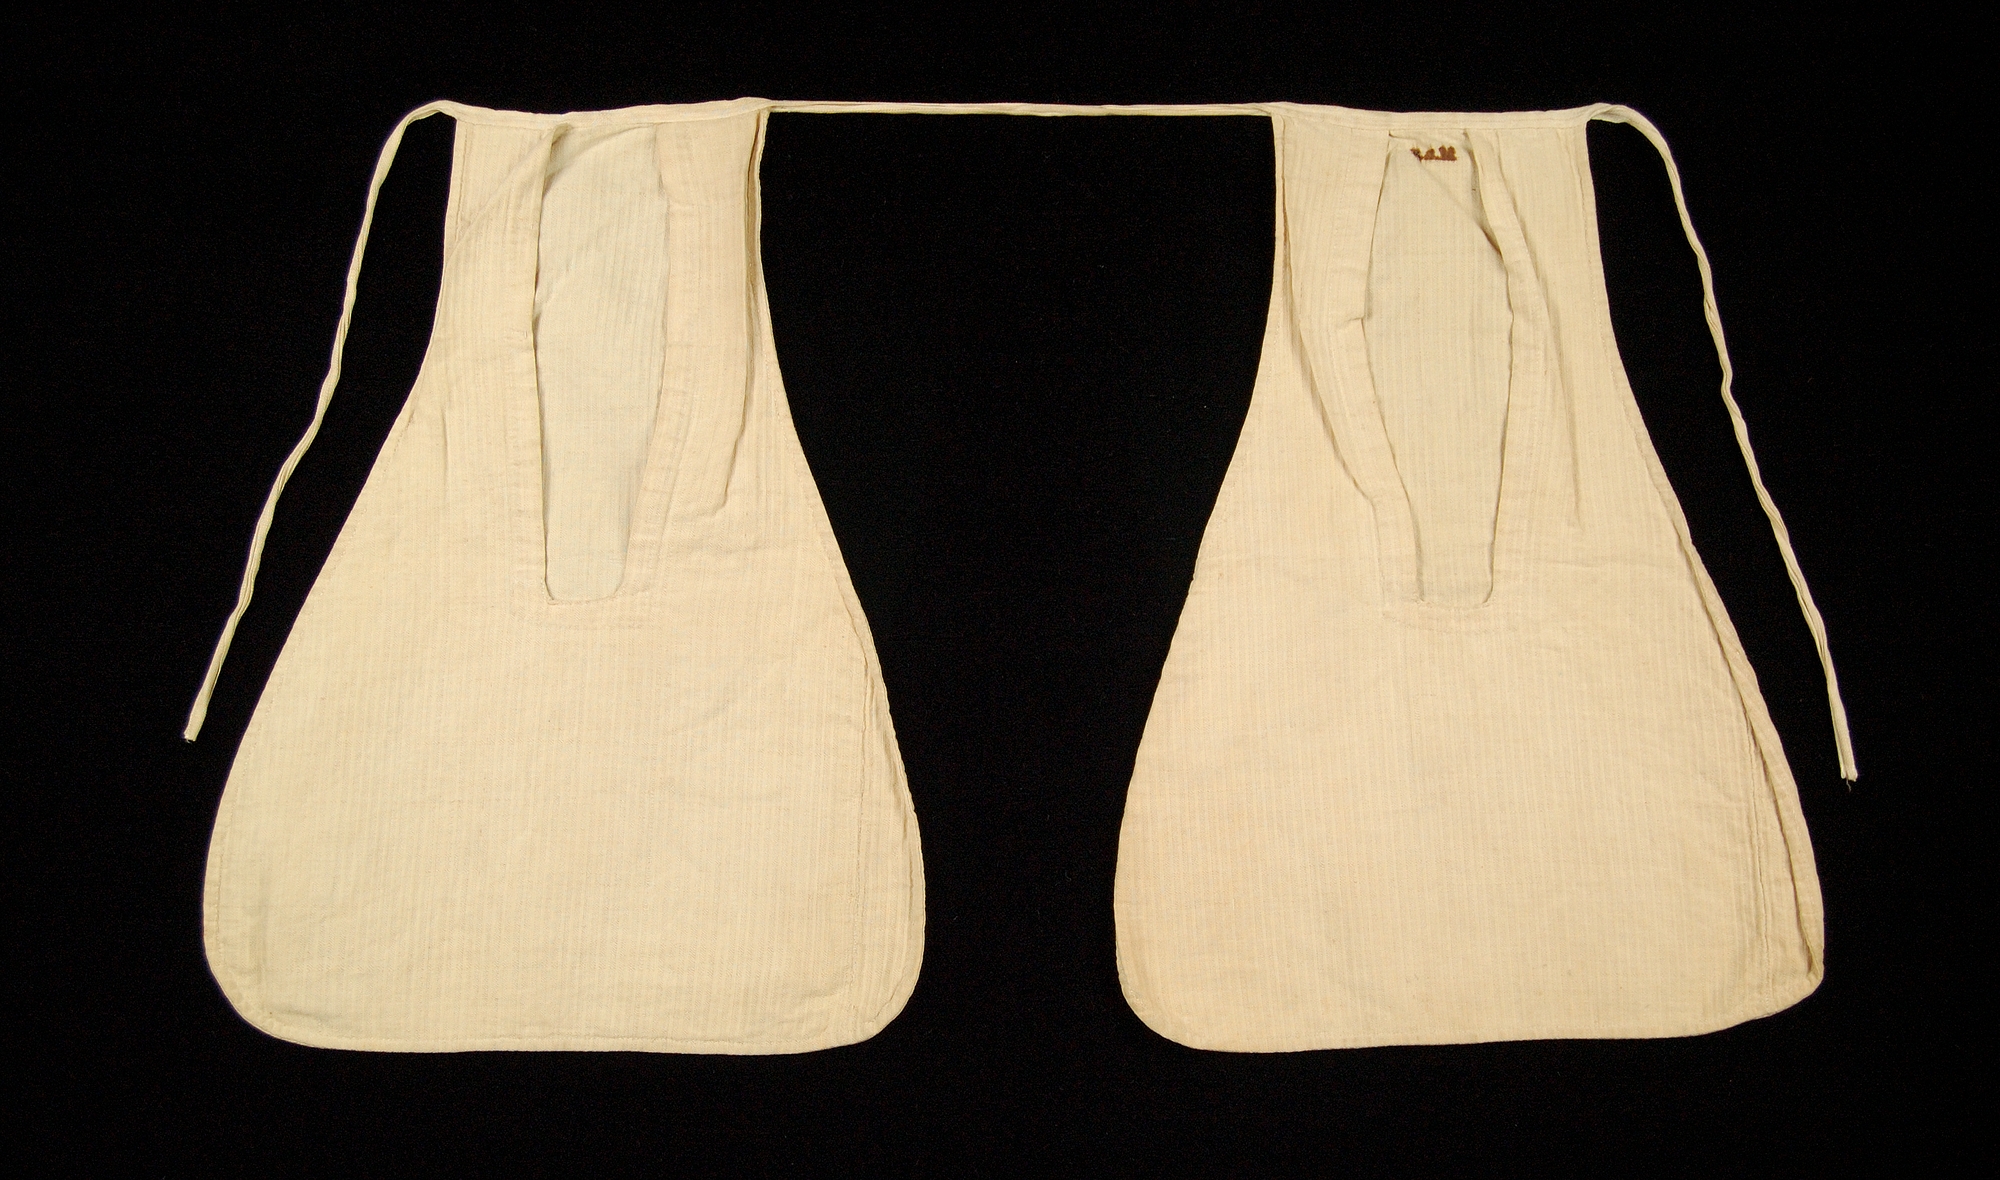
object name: pocket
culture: american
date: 1800-1810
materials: linen